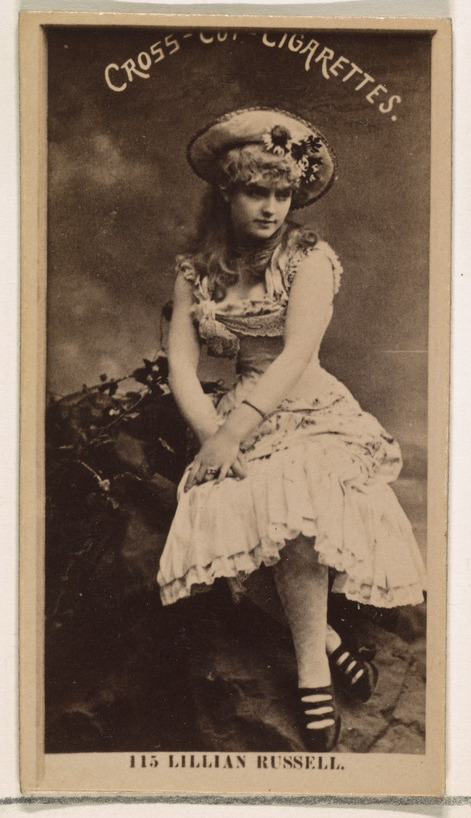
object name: print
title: Card Number 115, Lillian Russell, from the Actors and Actresses series (N145-2) issued by Duke Sons & Co. to promote Cross Cut Cigarettes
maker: w. duke, sons & co.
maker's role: publisher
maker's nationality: american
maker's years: 1870-1920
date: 1880-1889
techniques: albumen silver print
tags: portraits,women,actresses